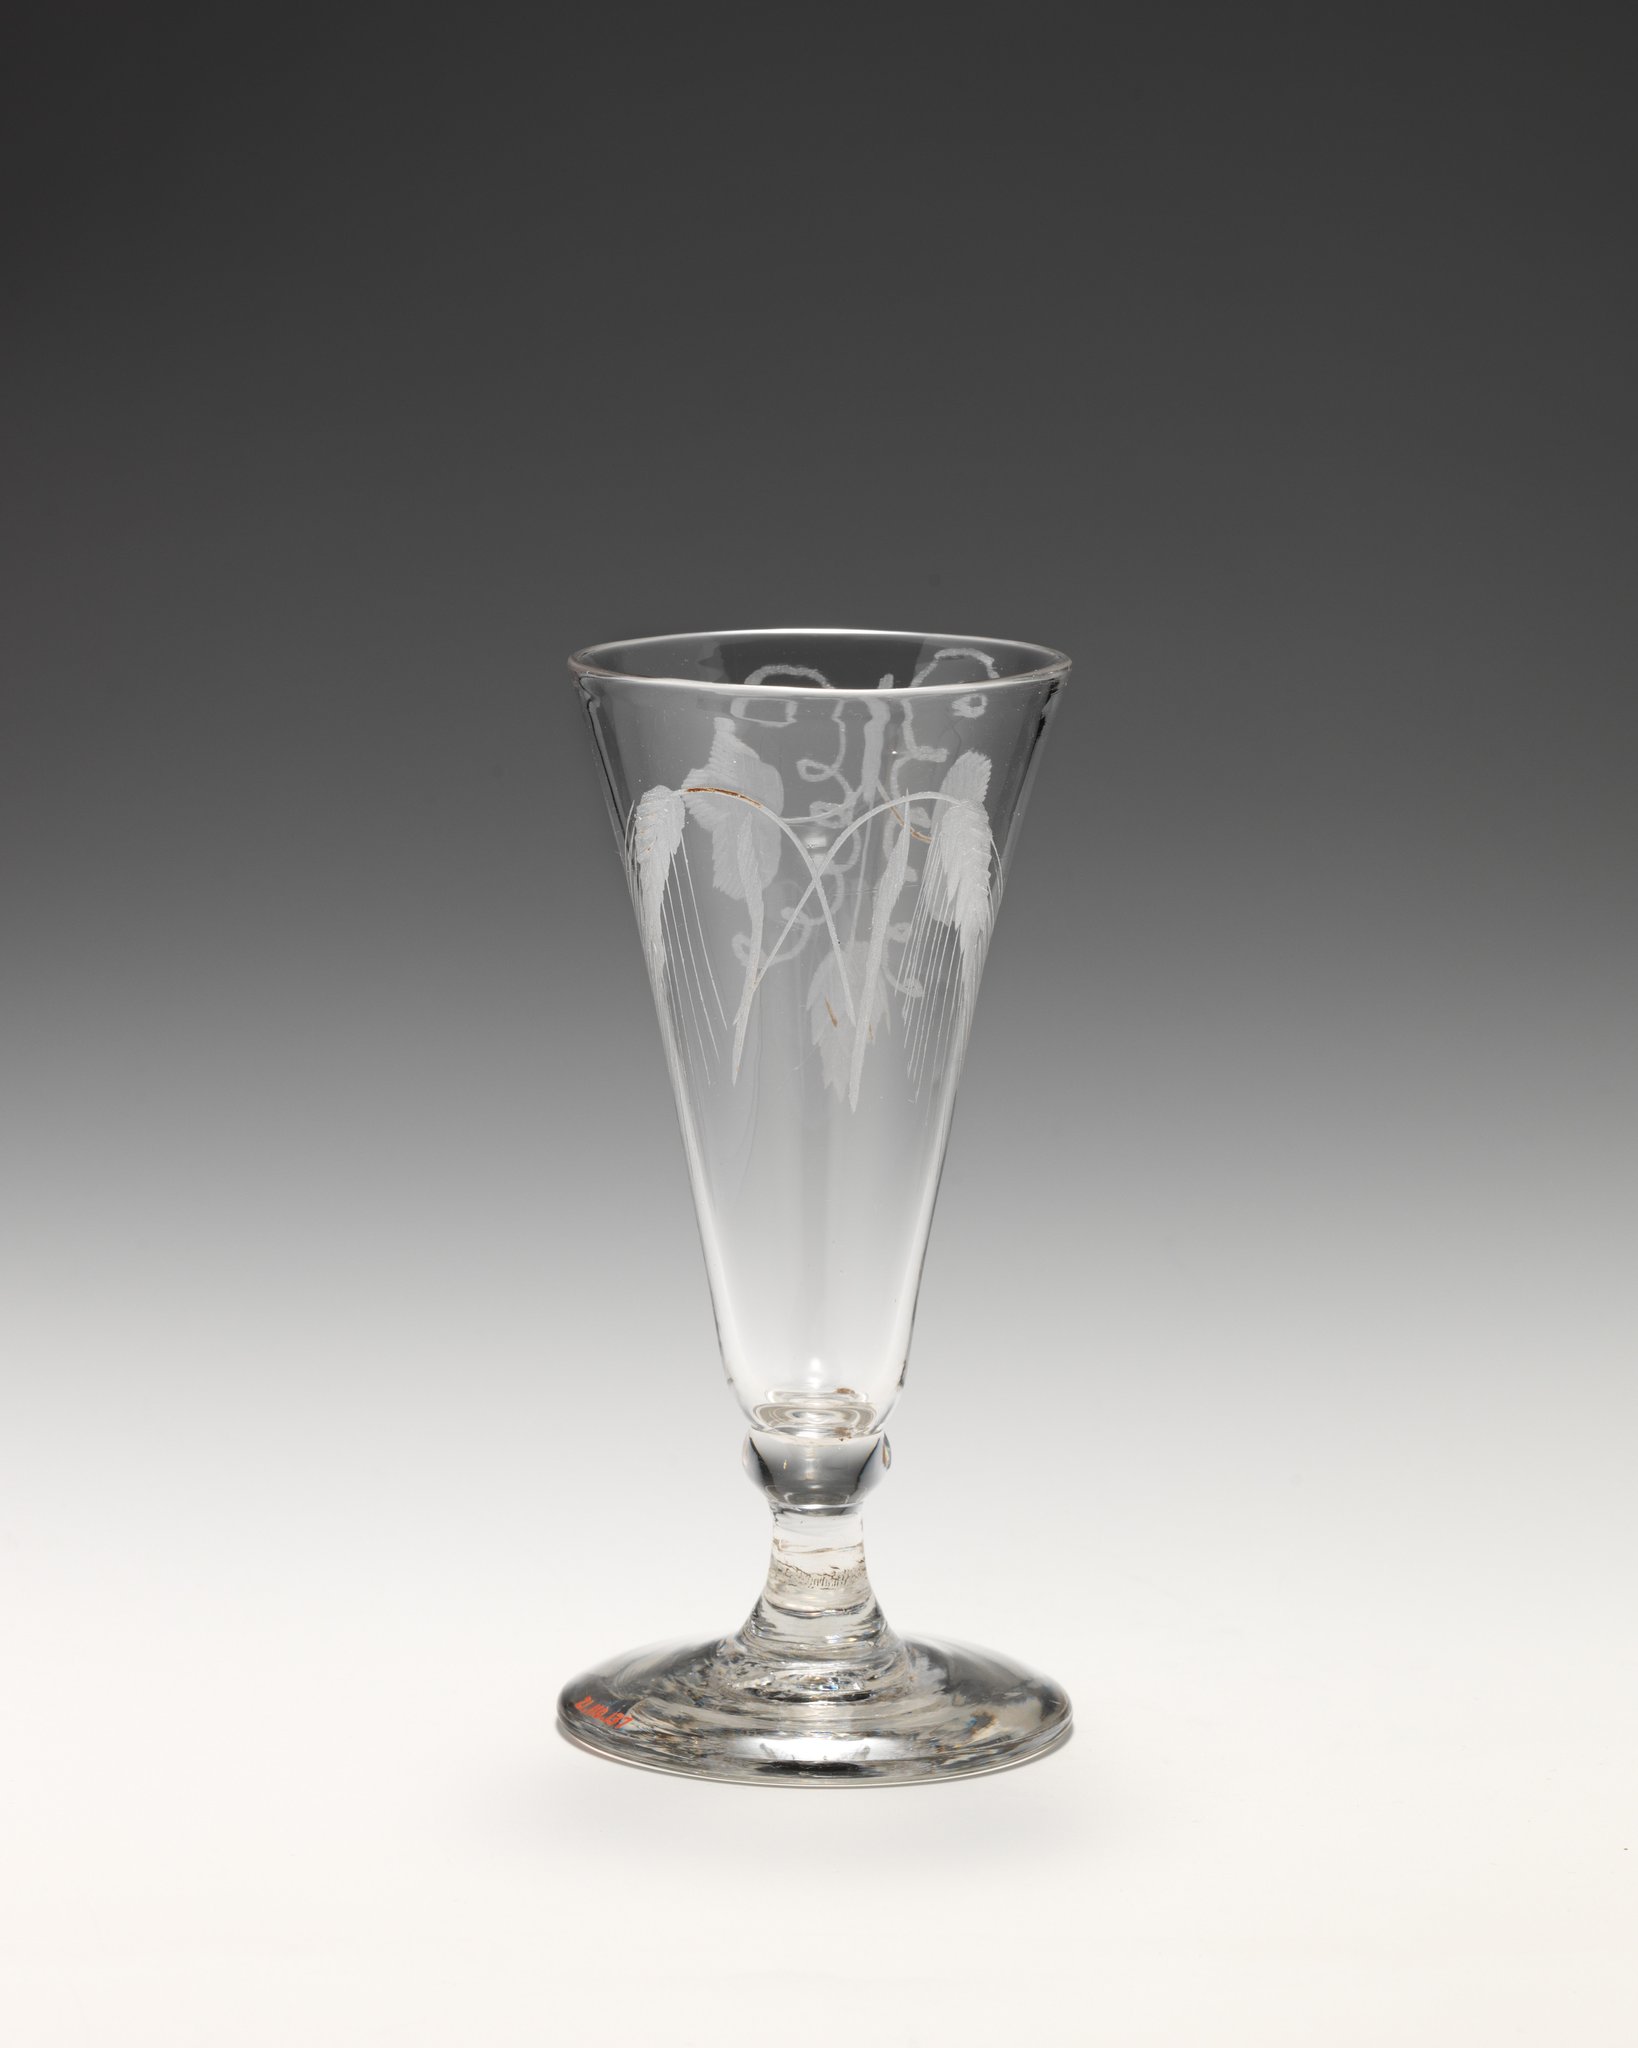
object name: ale glass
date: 1701-1800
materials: glass